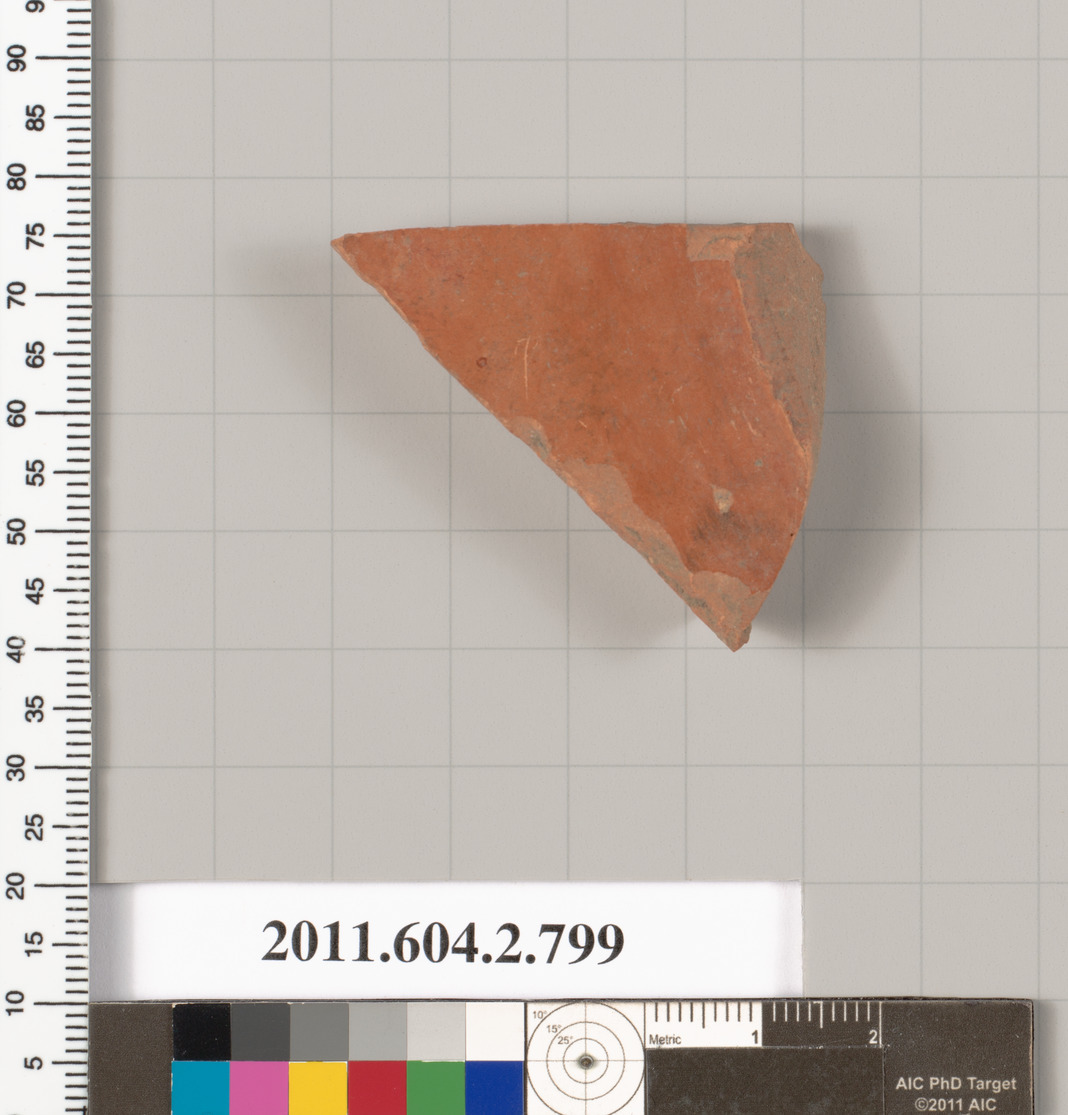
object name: calyx krater fragment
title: Terracotta fragment of a calyx-krater (bowl for mixing wine and water)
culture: greek, attic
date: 600-501 BCE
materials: terracotta